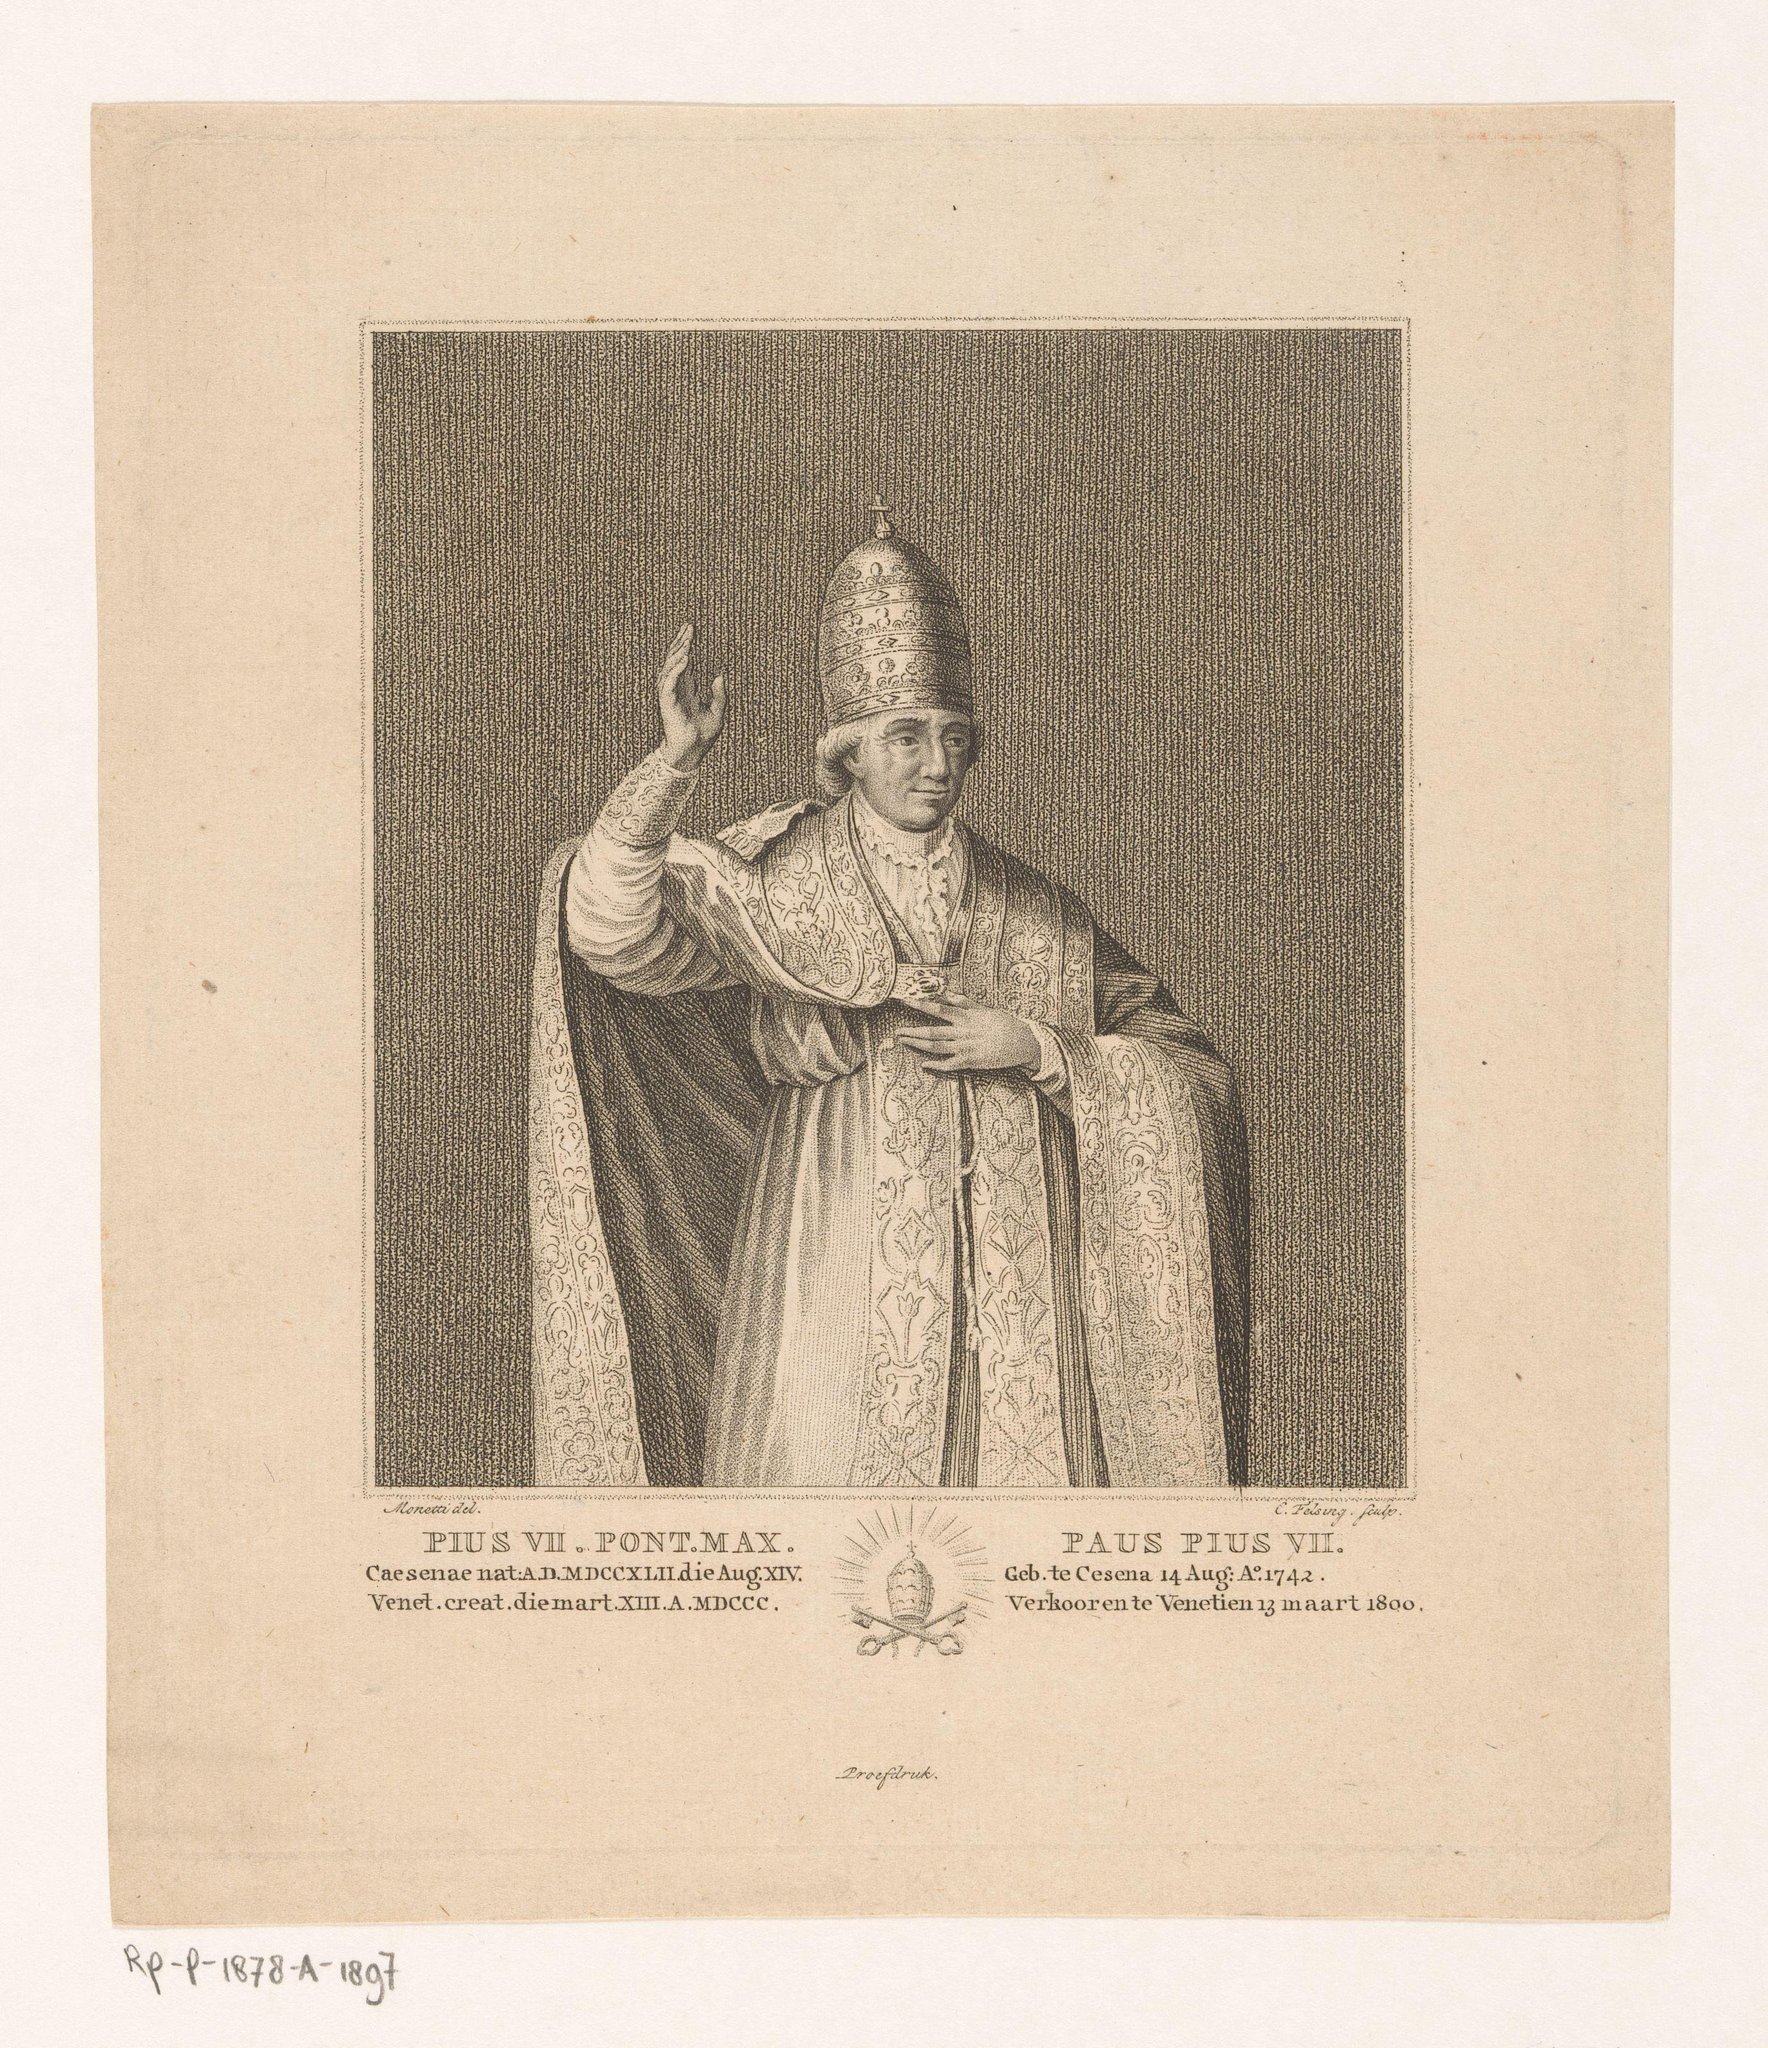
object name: print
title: Portret van paus Pius VII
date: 1800-1819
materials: paper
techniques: engraving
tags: rome, clergyman, pius vii, insignia of the pope, e.g. tiara, historical persons, pope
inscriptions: collector's mark: Lugt 2228